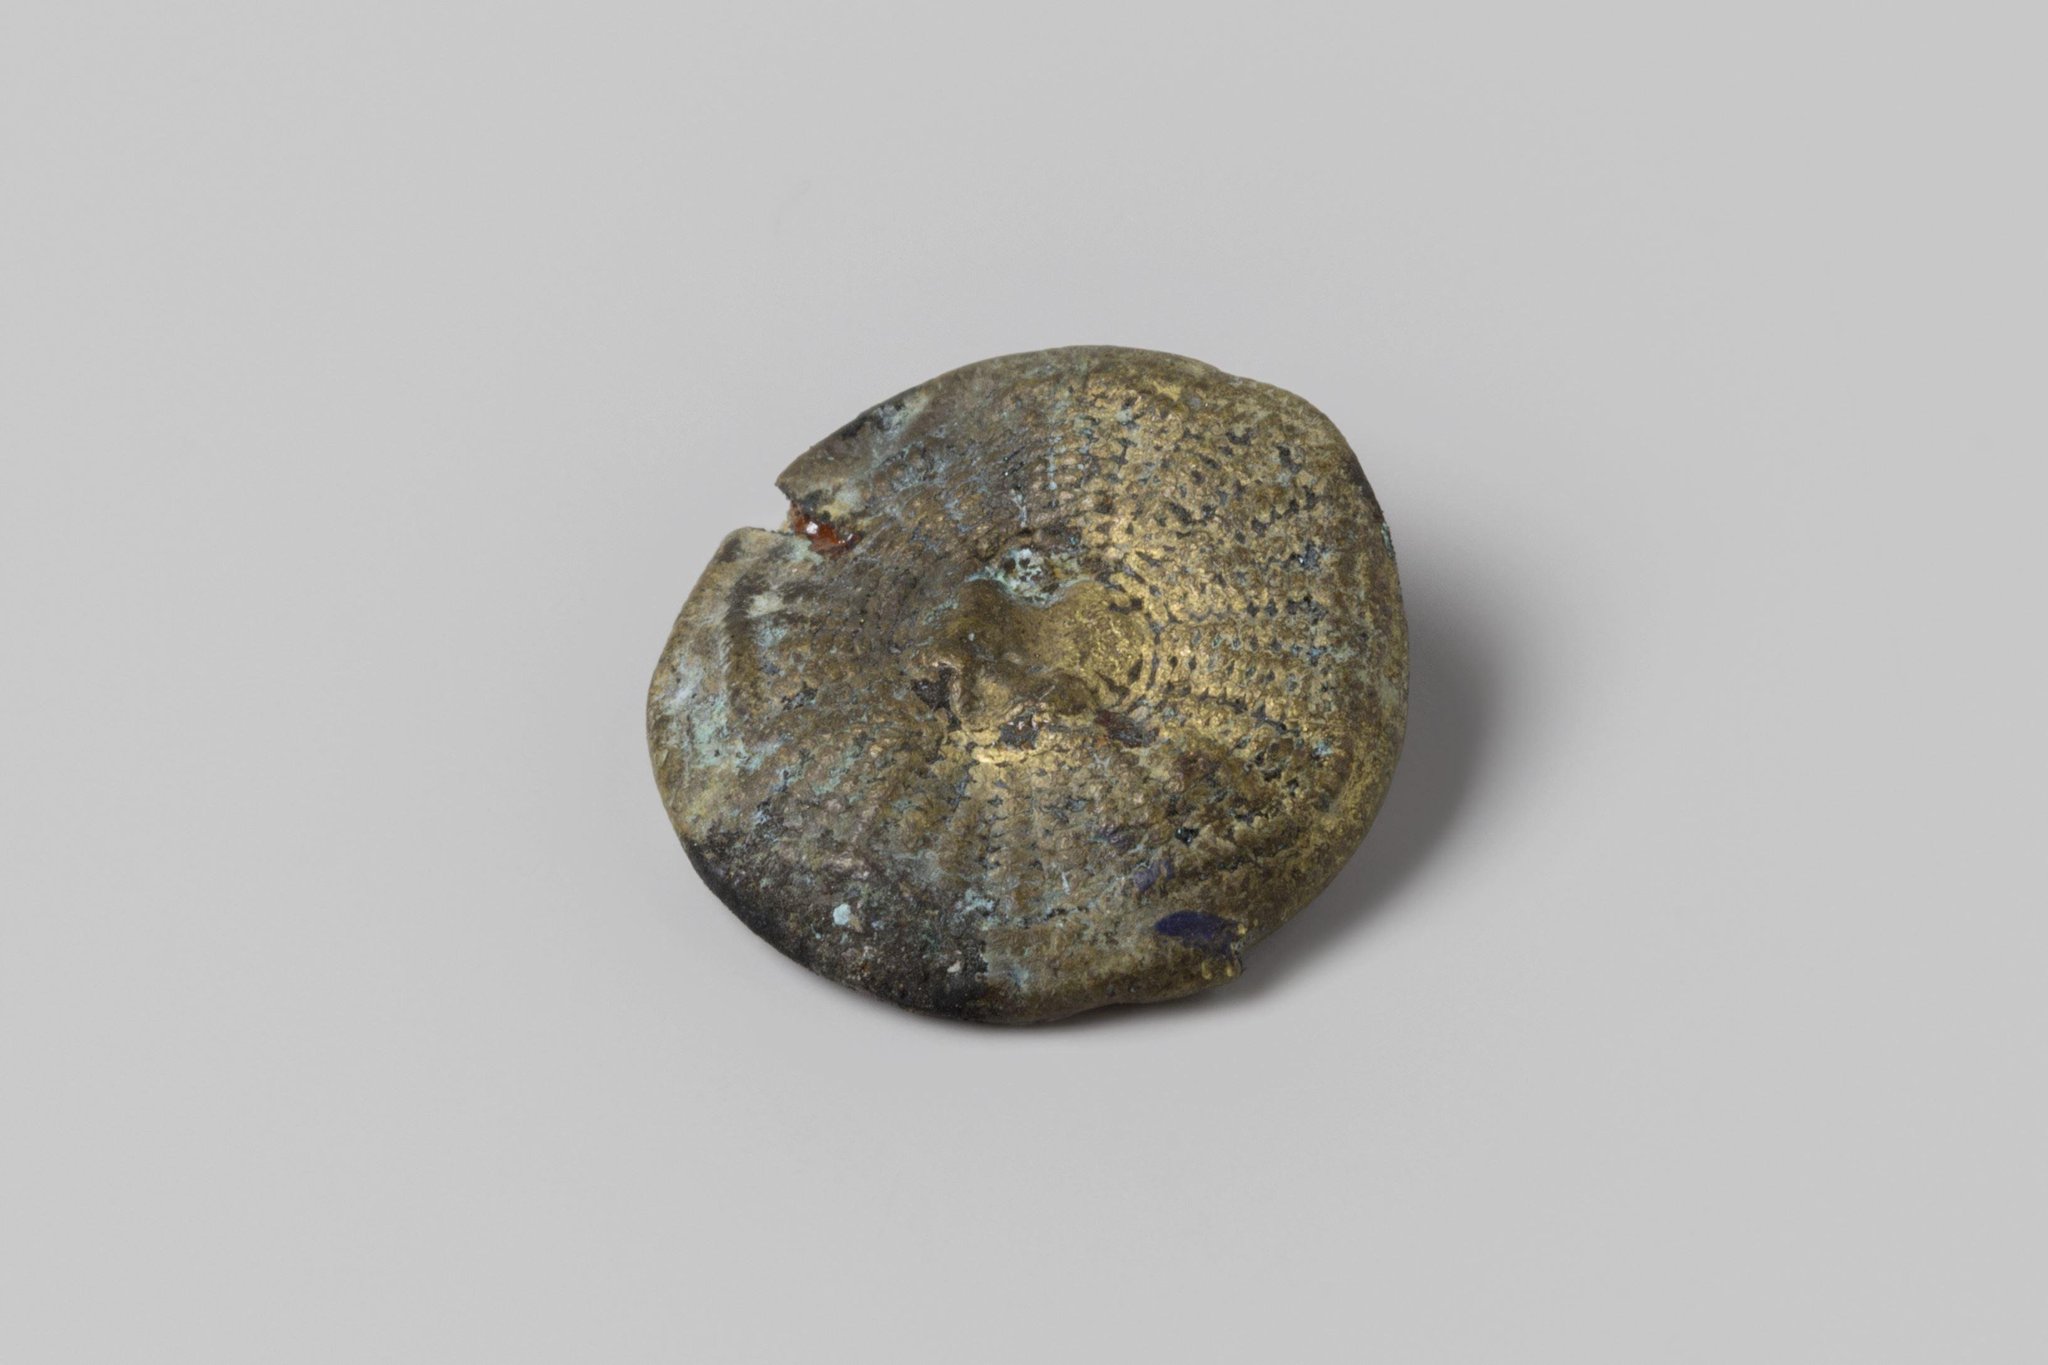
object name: button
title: Knoop uit het wrak van de Oost-Indiëvaarder Hollandia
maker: Anonymous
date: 1700-1743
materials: copper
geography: netherlands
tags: verenigde oostindische compagnie, hollandia (schip), annet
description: Knoop. (1) fragm, top, relieved wickerwork motif (1.9d, 0.5t), squashed, filled with (w)